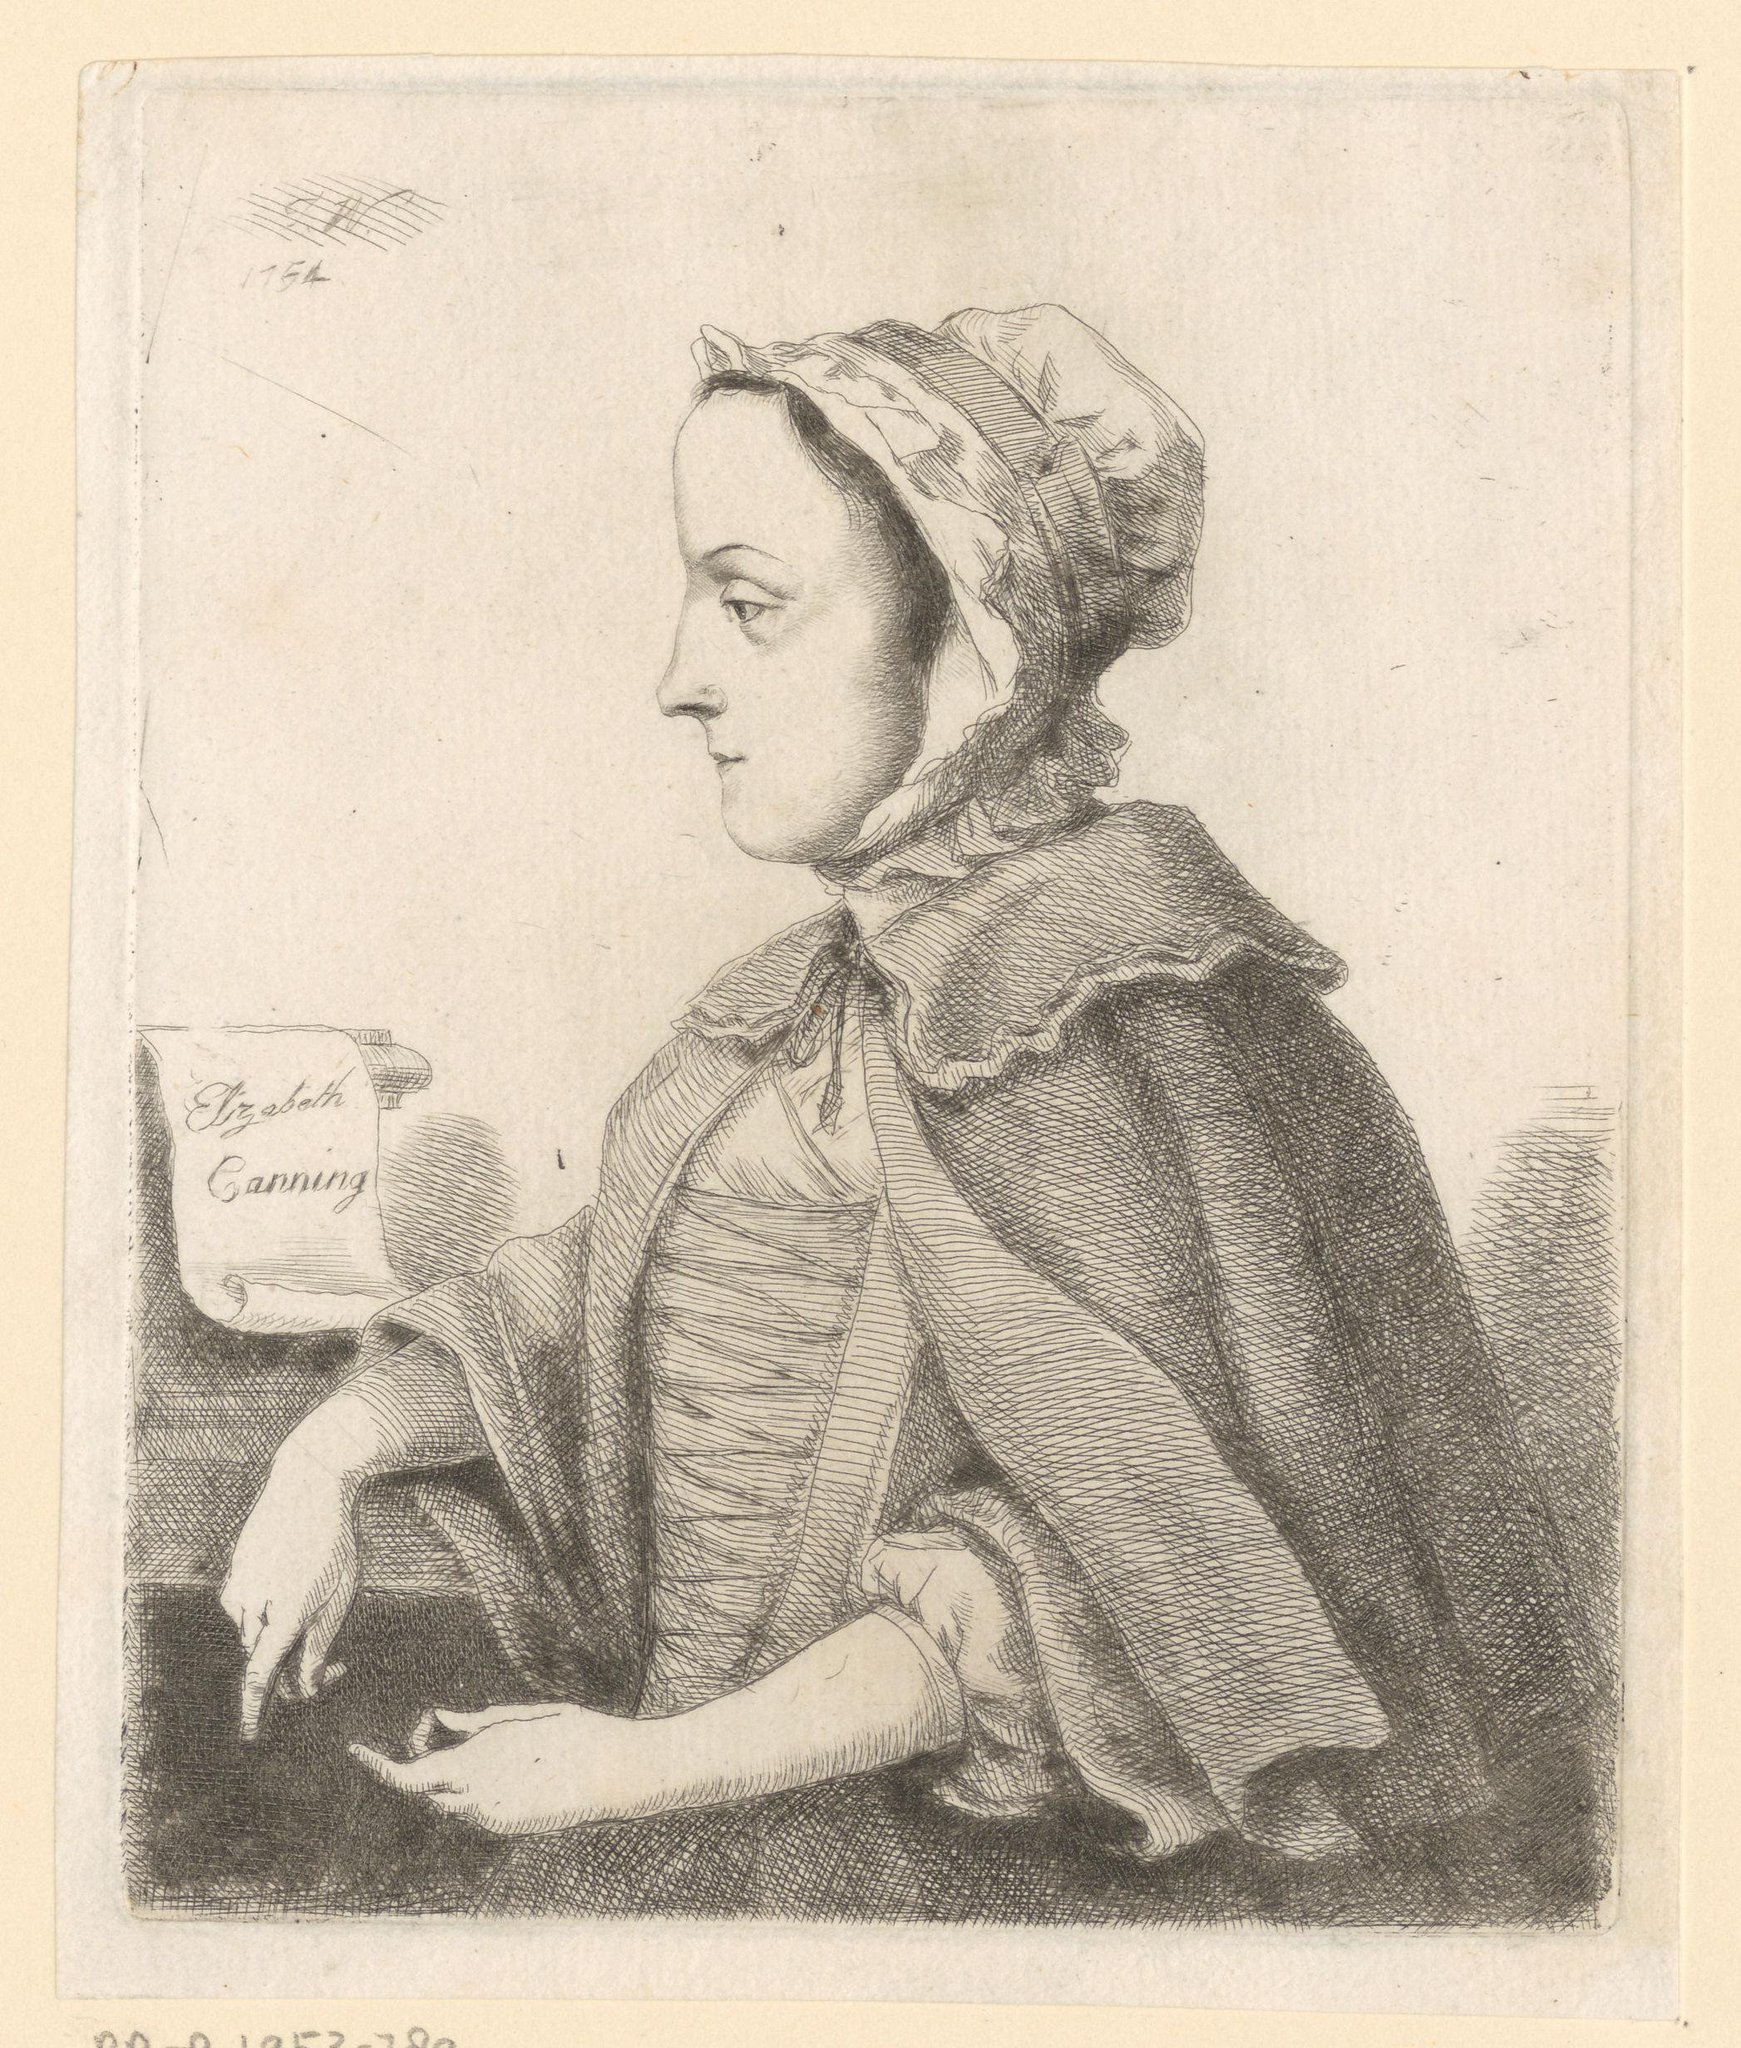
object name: print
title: Elizabeth Canning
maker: thomas worlidge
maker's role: print maker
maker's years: 1700-1766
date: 1754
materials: paper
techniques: drypoint, etching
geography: london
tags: cape, historical person (with name) - bb - woman - historical person (with name) portrayed alone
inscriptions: collector's mark: Lugt 2760, collector's mark: Lugt 2228